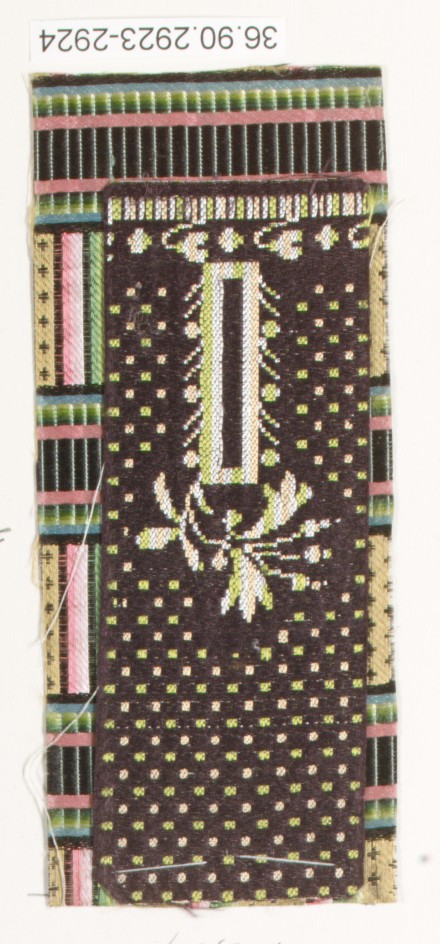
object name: piece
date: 1801-1900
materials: silk